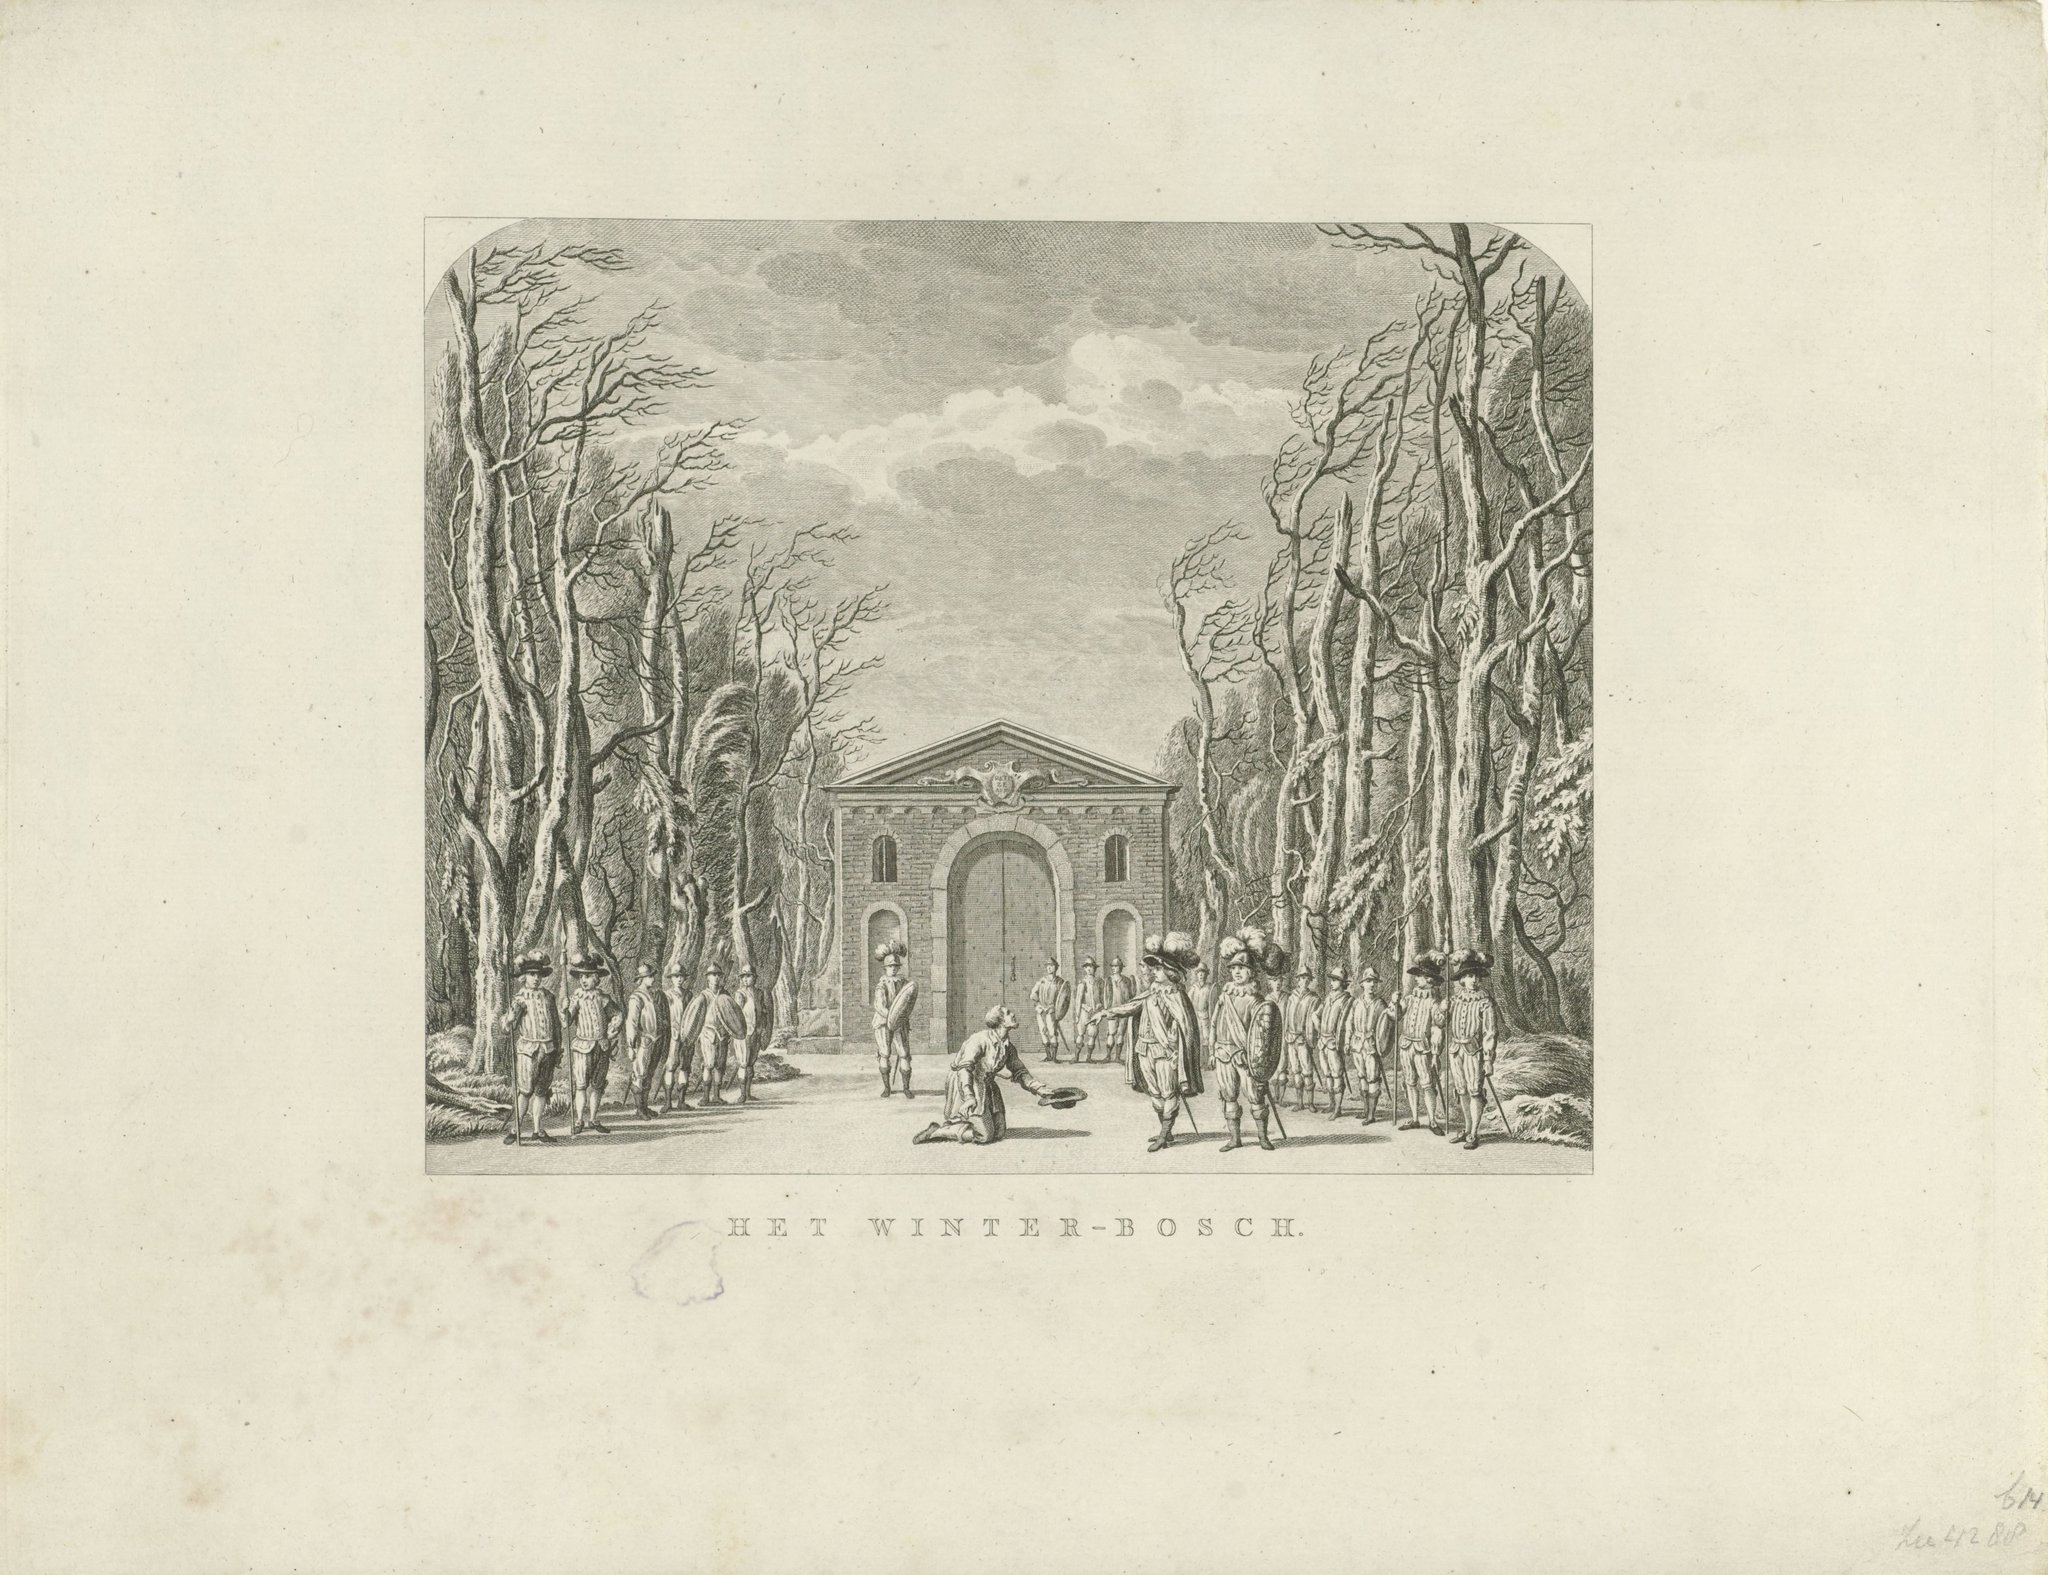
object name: print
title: Het Winter Bosch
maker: cornelis brouwer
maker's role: print maker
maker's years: 1731-1803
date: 1788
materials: paper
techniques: engraving, etching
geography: northern netherlands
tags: stage design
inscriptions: collector's mark: Lugt 2228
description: Het coulissendecor Het Winter Bosch, met scène uit de Gysbrecht van Aemstel. Aparte afdruk van alleen het decor, zonder de passe-partout met het toneel en de zaal. Behorend bij de serie van veertien toneeldecors van de nieuwe Amsterdamse Schouwburg, 1787-1794.